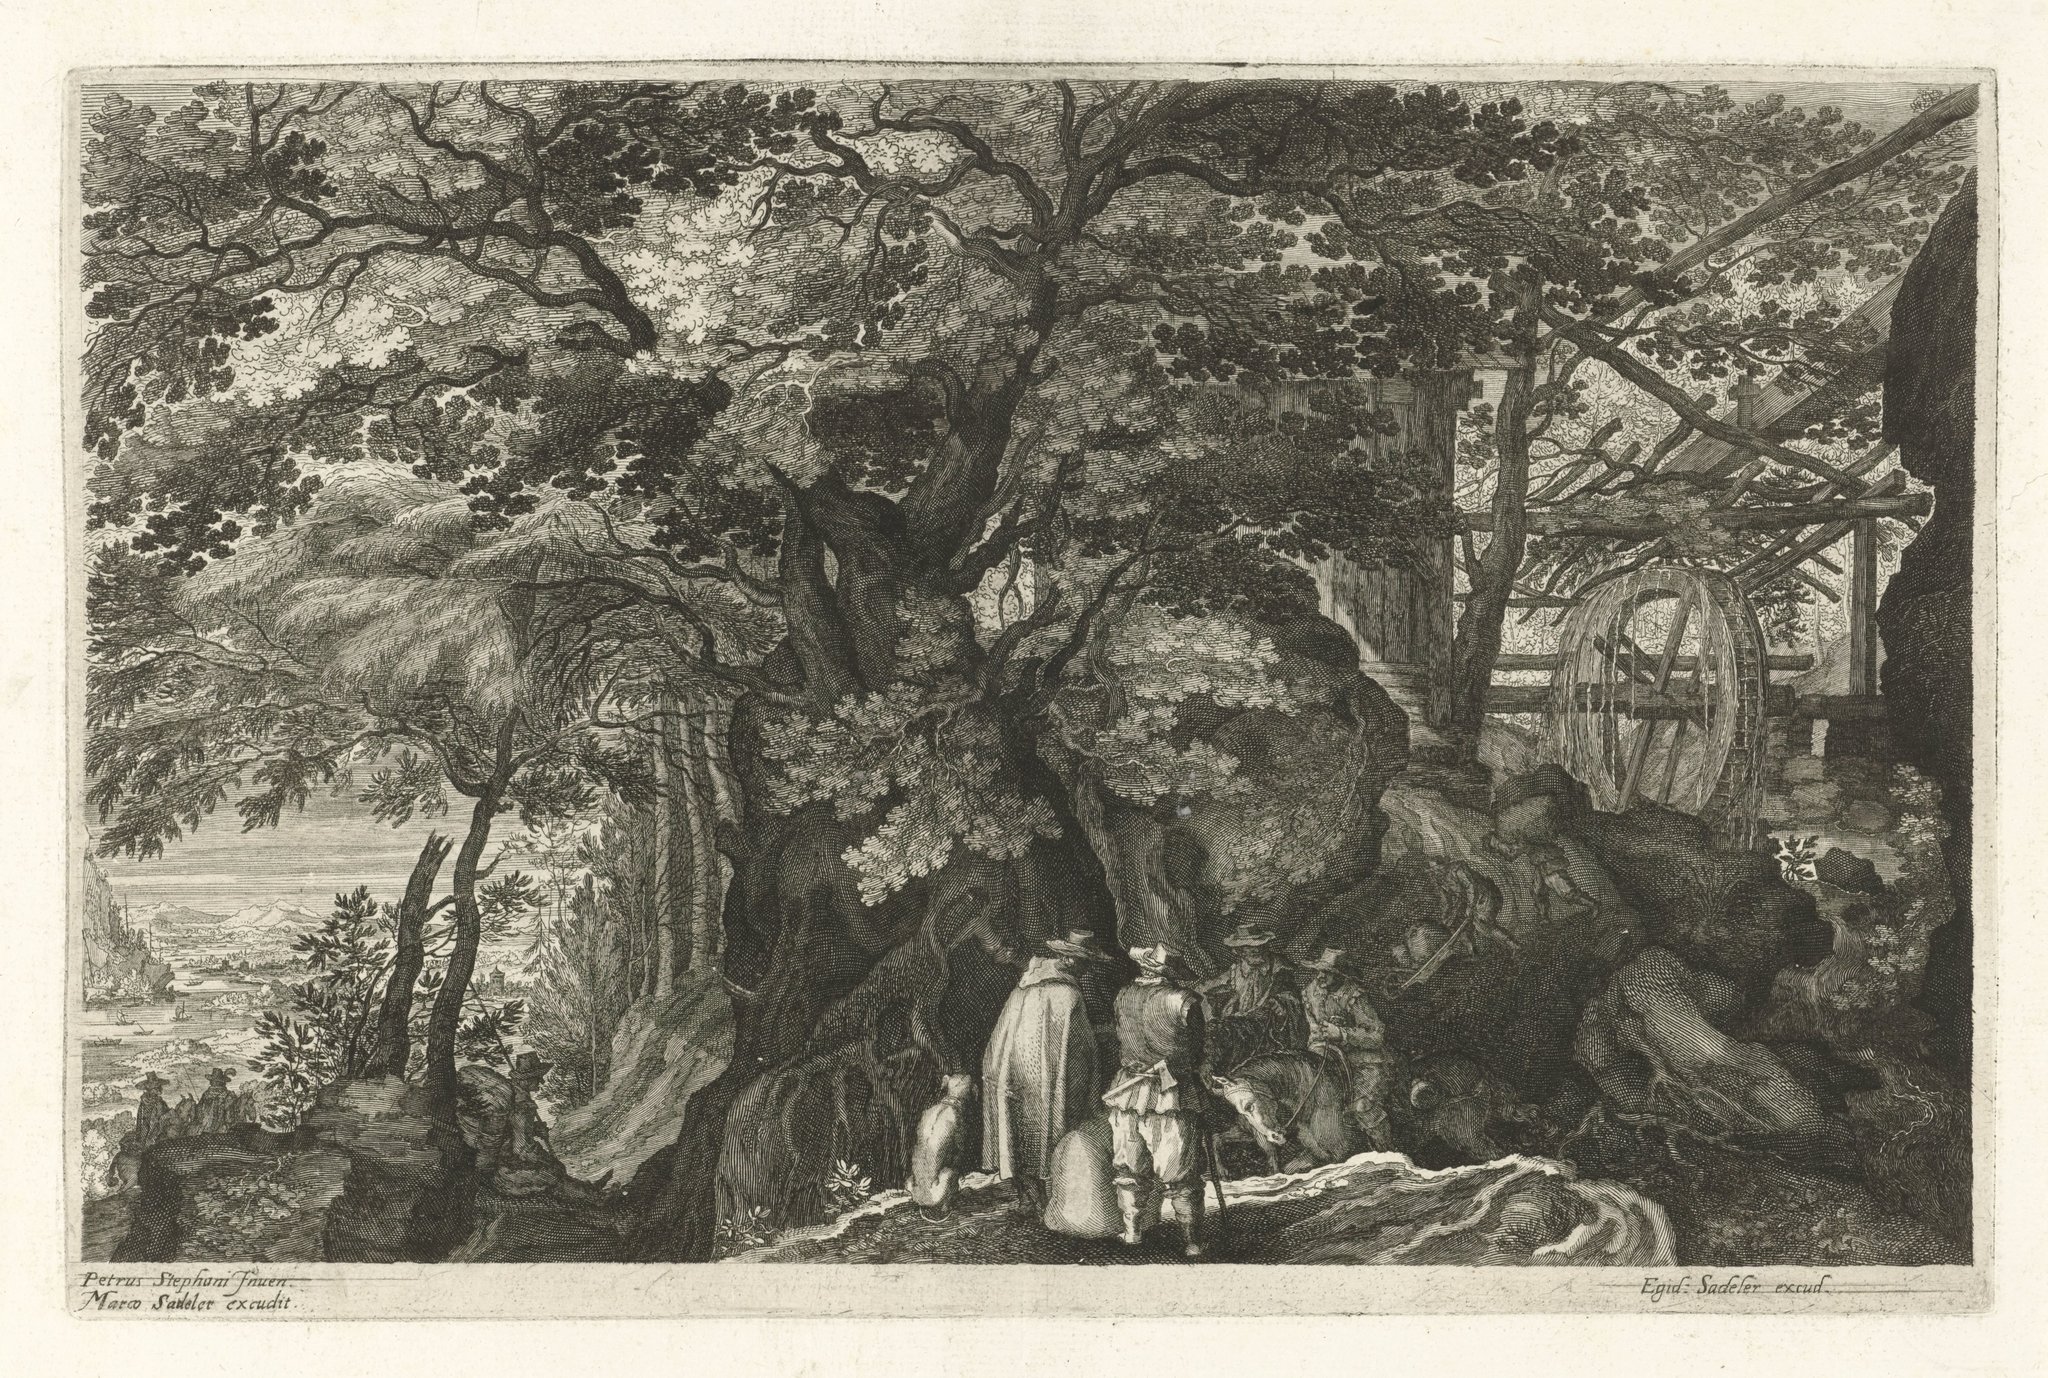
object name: print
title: Rivier met rotsen en een watermolen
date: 1597-1629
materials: paper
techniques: engraving, etching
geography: venice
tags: watermill, 'en route', traveller under way, river (+ landscape with figures, staffage)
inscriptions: collector's mark: Lugt 240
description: Rivier met rotsen. Op de voorgrond reizigers te voet en te paard. Op de rechterachtergrond een watermolen. De derde prent van een achtdelige reeks met landschappen in Bohemen